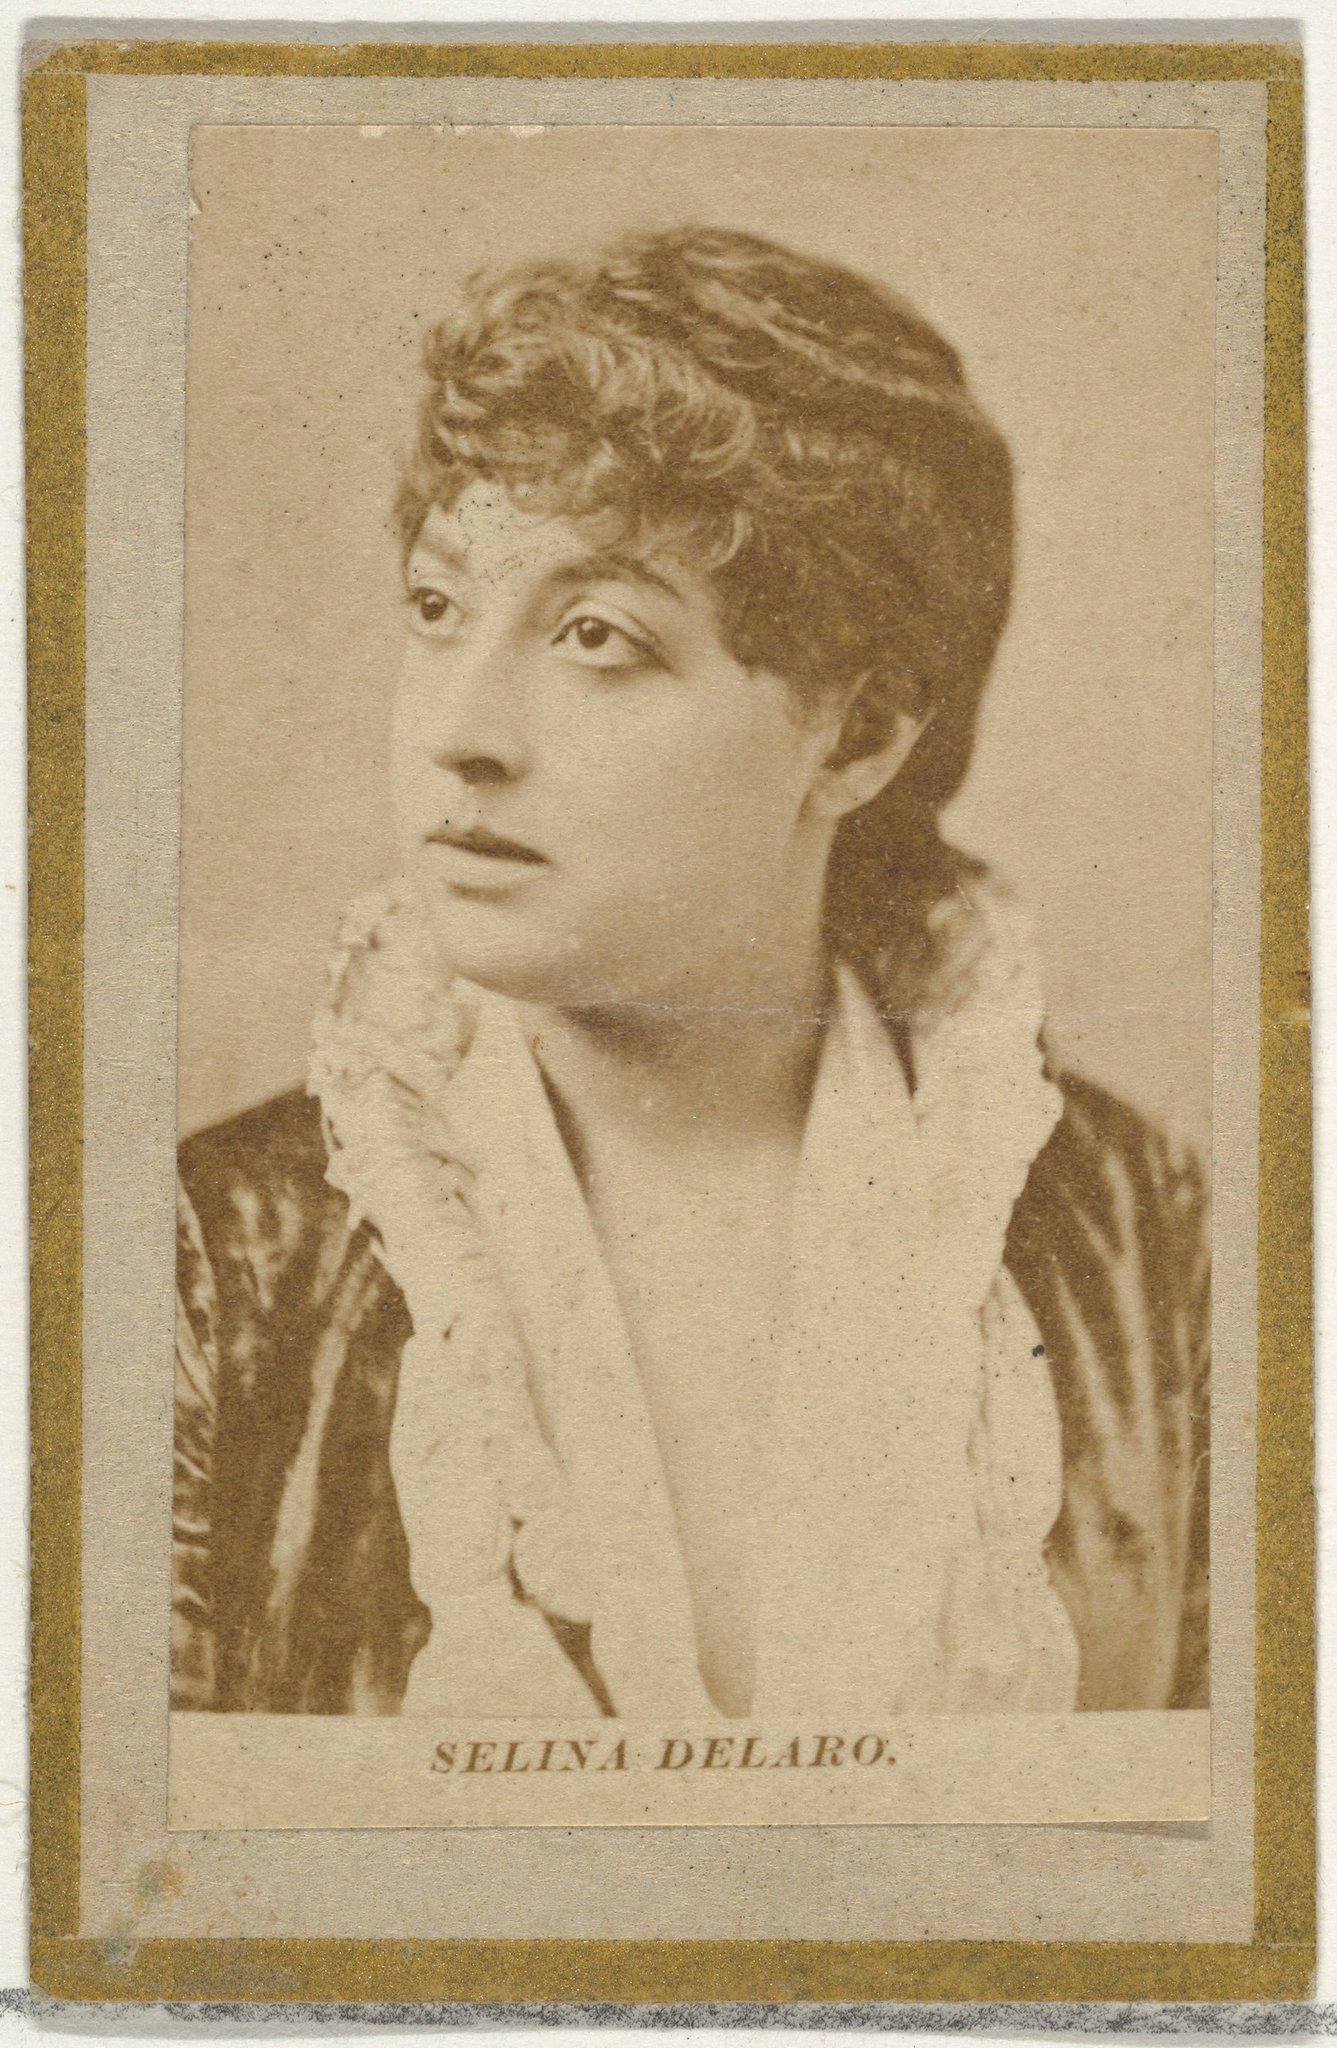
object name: photograph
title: Selina Delaro, from the Actresses and Celebrities series (N60, Type 2) promoting Little Beauties Cigarettes for Allen & Ginter brand tobacco products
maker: allen & ginter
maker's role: publisher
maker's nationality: american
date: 1887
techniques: albumen silver print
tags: portraits,women,actresses